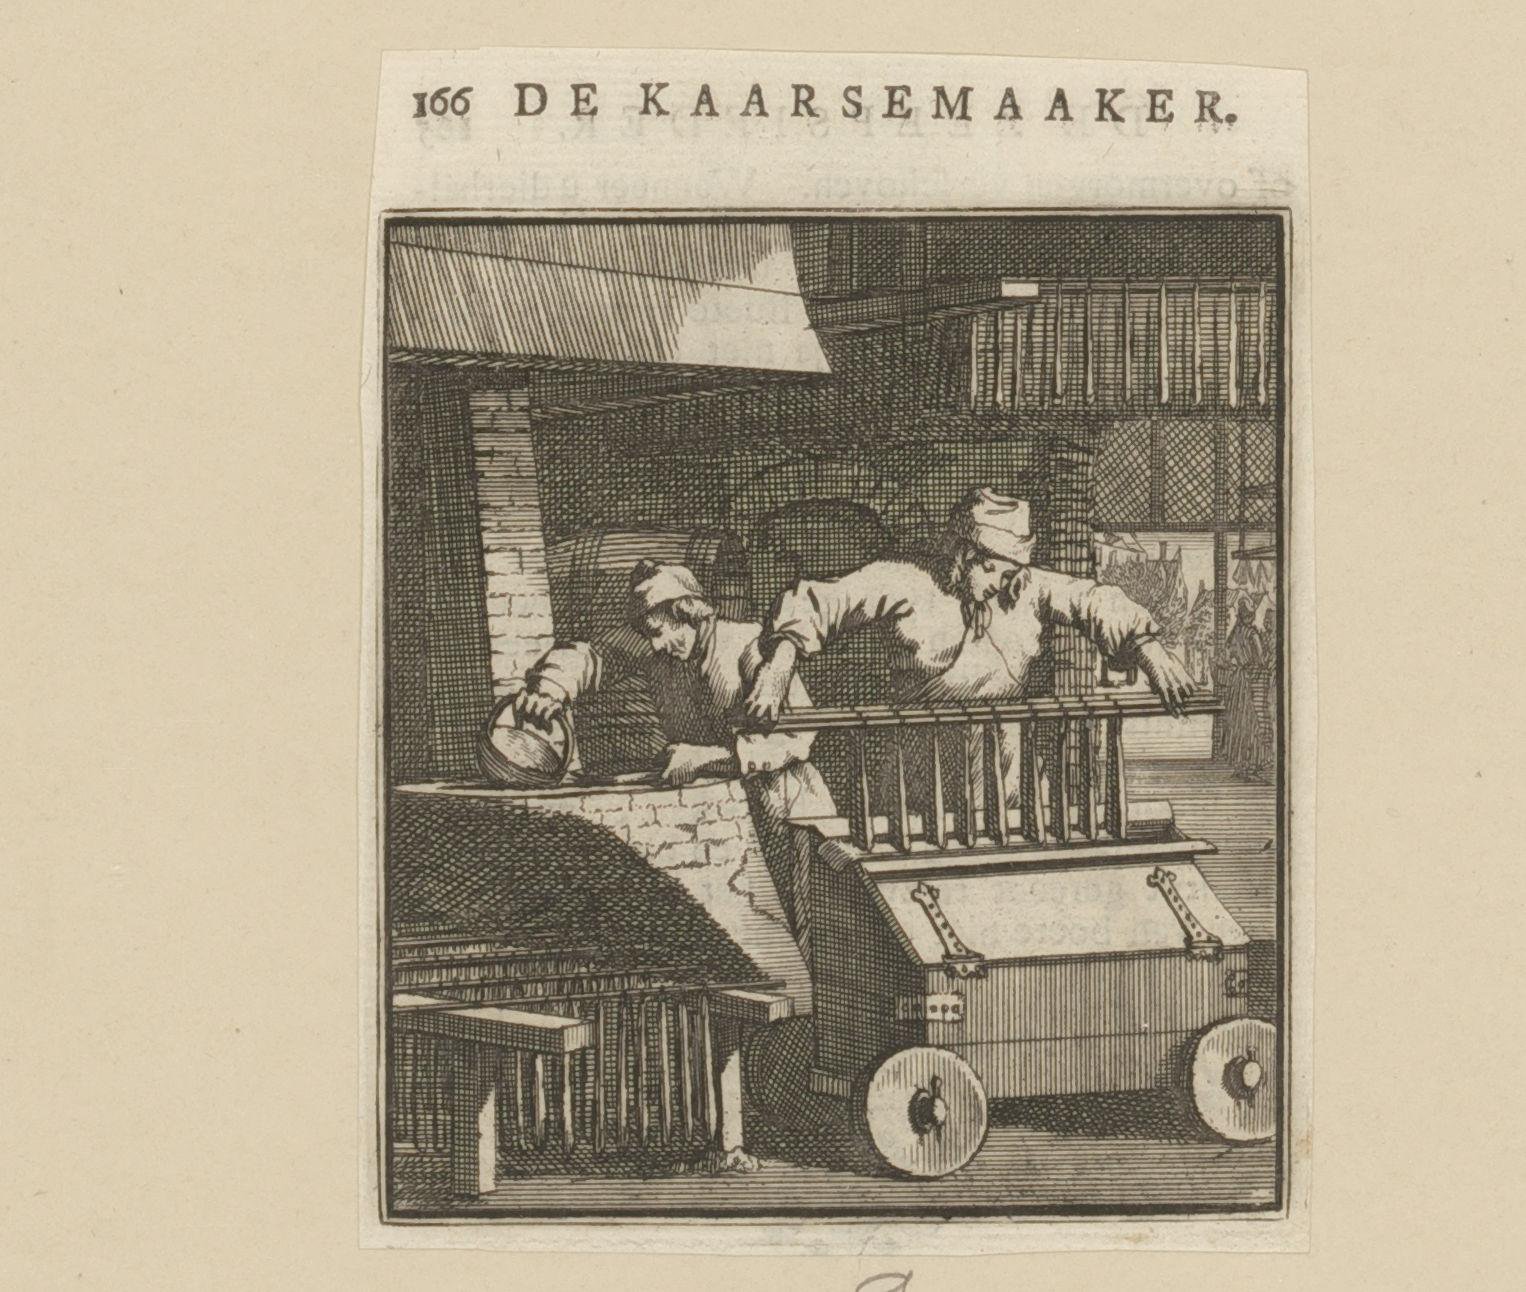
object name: print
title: Twee kaarsenmakers aan het werk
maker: Anonymous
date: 1719-1759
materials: paper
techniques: etching, letterpress printing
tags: handicrafts, craftsman at work, candle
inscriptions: stamp, collector's mark: Lugt 1641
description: Prent met andere letterzetting gebruikt in: St. Clara, Abraham van. Iets voor allen. [Vertaald door] J. le Long. Amsterdam: Janssoons van Waesberge, 1719, dl. 2. En in: St. Clara, Abraham van. Iets voor allen. [Vertaald door] J. le Long. Amsterdam: Jan Roman de Jonge, 1741, dl. 2. En in: St. Clara, Abraham van. Iets voor allen. [Vertaald door] J. le Long. Amsterdam: Jan Roman, 1759, dl. 2. Huidige prent uit een andere editie. Naar een prent van: Jan Luyken.